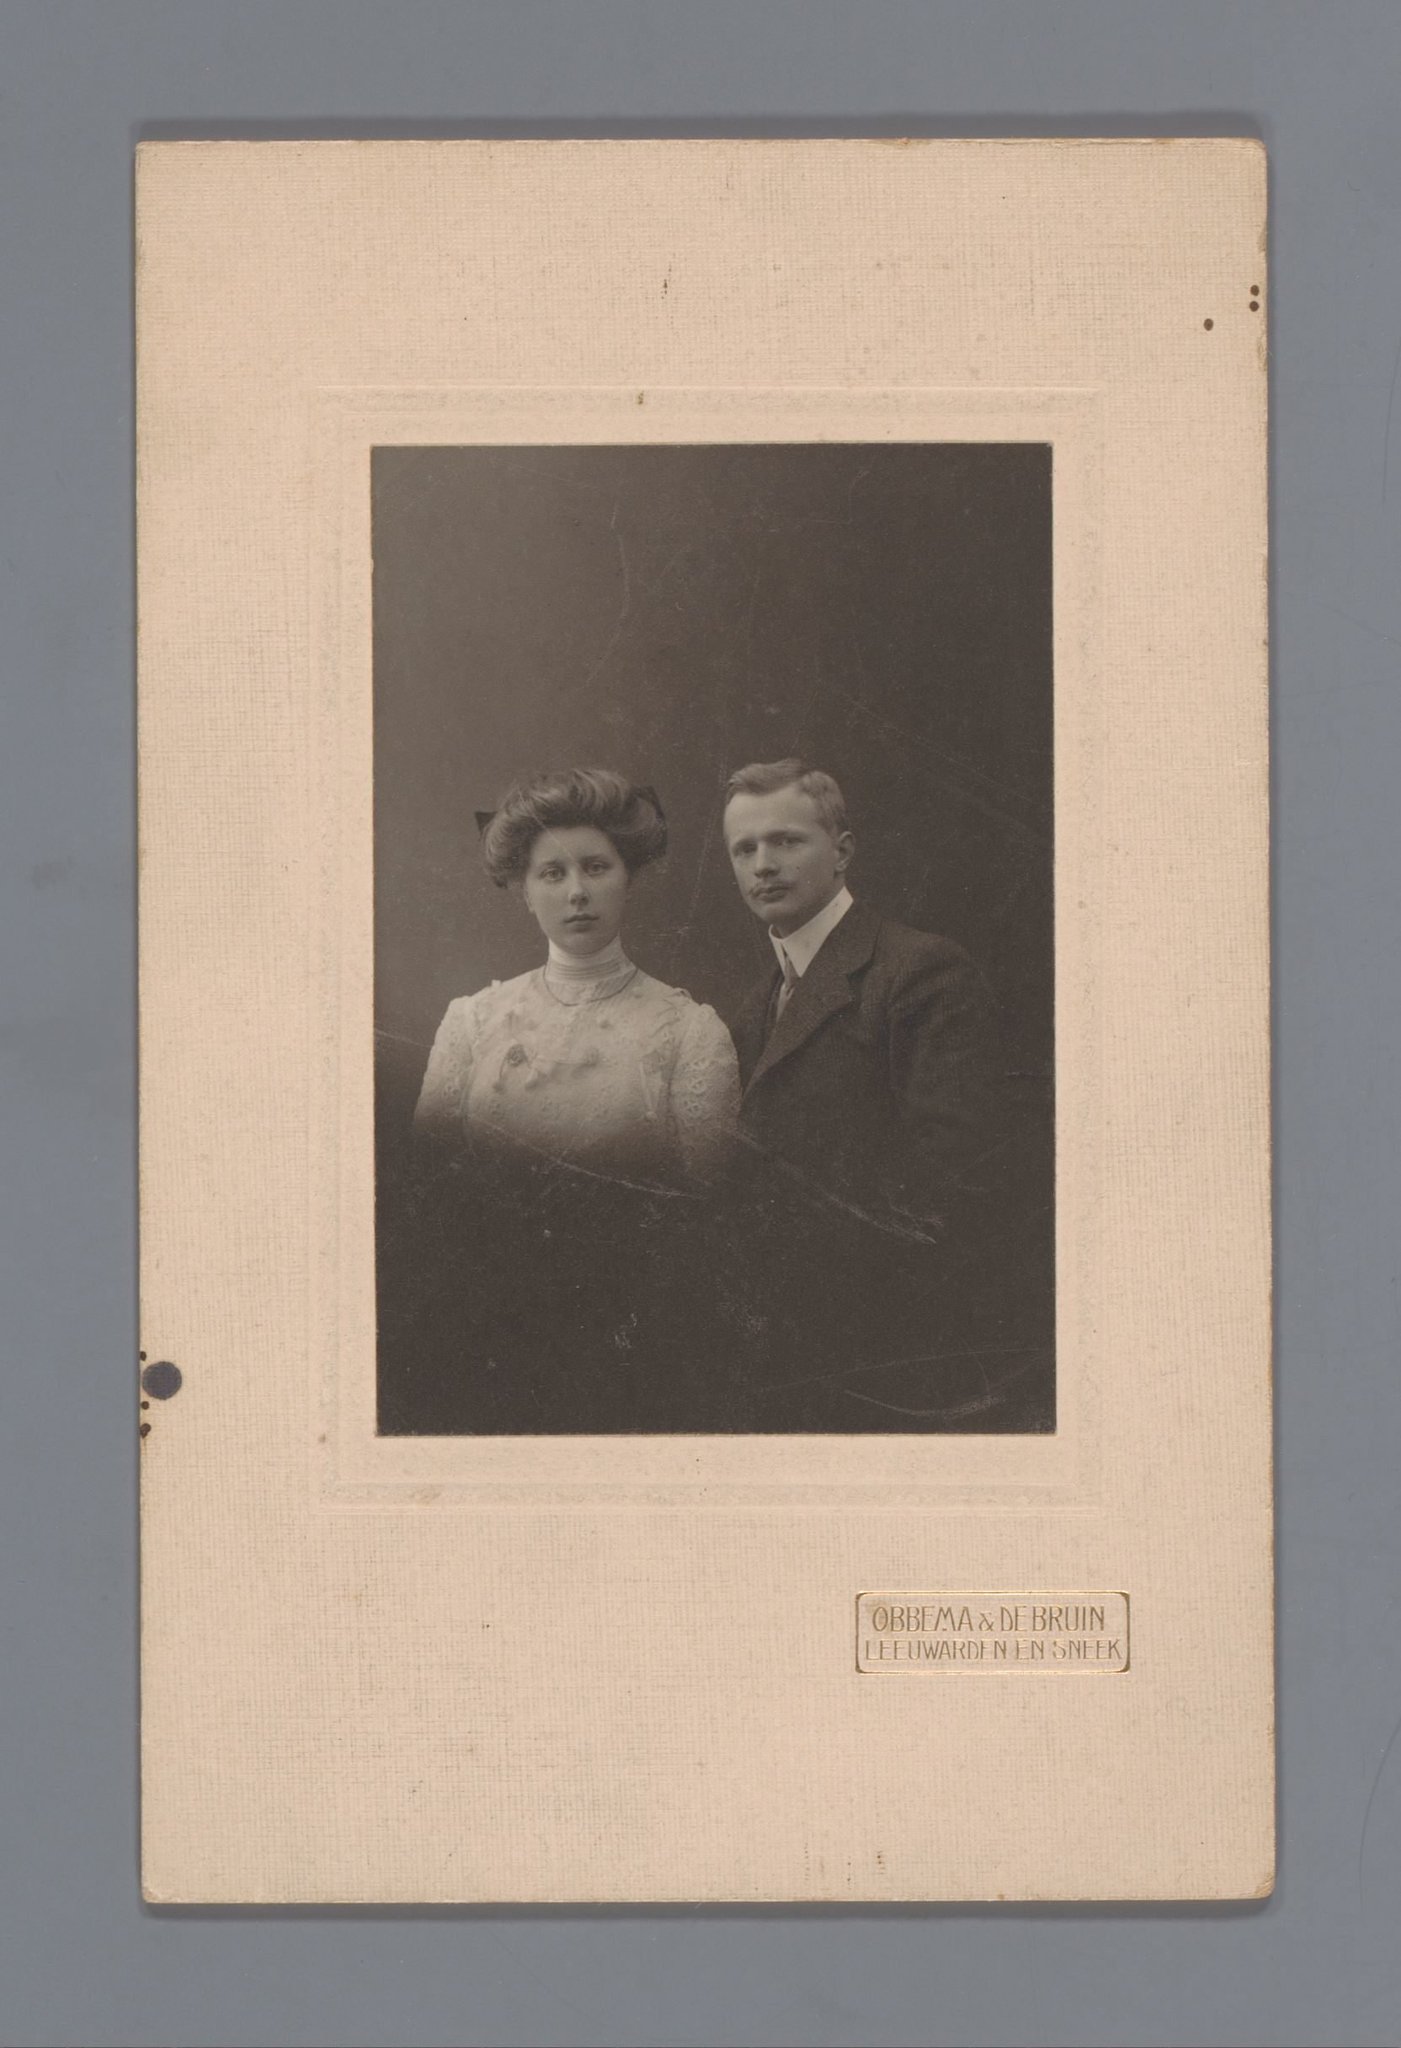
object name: photograph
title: Portret van een onbekende man en vrouw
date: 1880-1900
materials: cardboard, photographic support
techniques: matte daylight collodion silver print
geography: friesland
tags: anonymous historical persons portrayed in a double portrait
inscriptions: inscription: ‘Obbema en de Bruin Leeuwarden voorheen Slaterus (...) Vergrootingen.’, name: ‘Obbema & De Bruin Leeuwarden en Sneek’